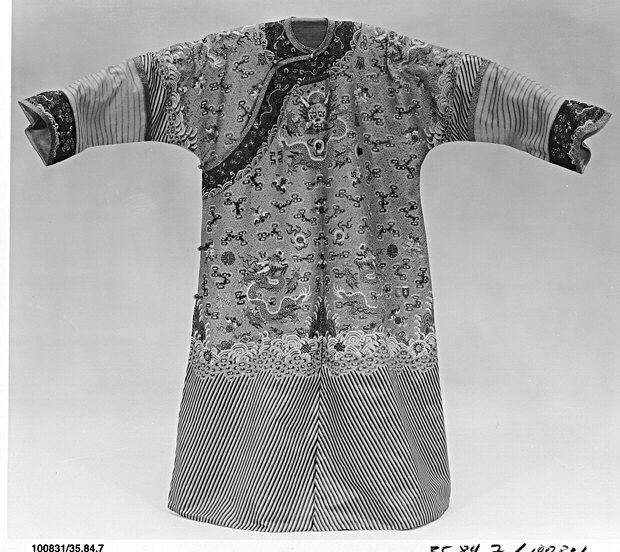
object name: robe, emperor's 12 symbol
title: Emperor's Twelve-Symbol Robe for Summer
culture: chinese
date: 1875-1908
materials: metal thread, silk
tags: dragons